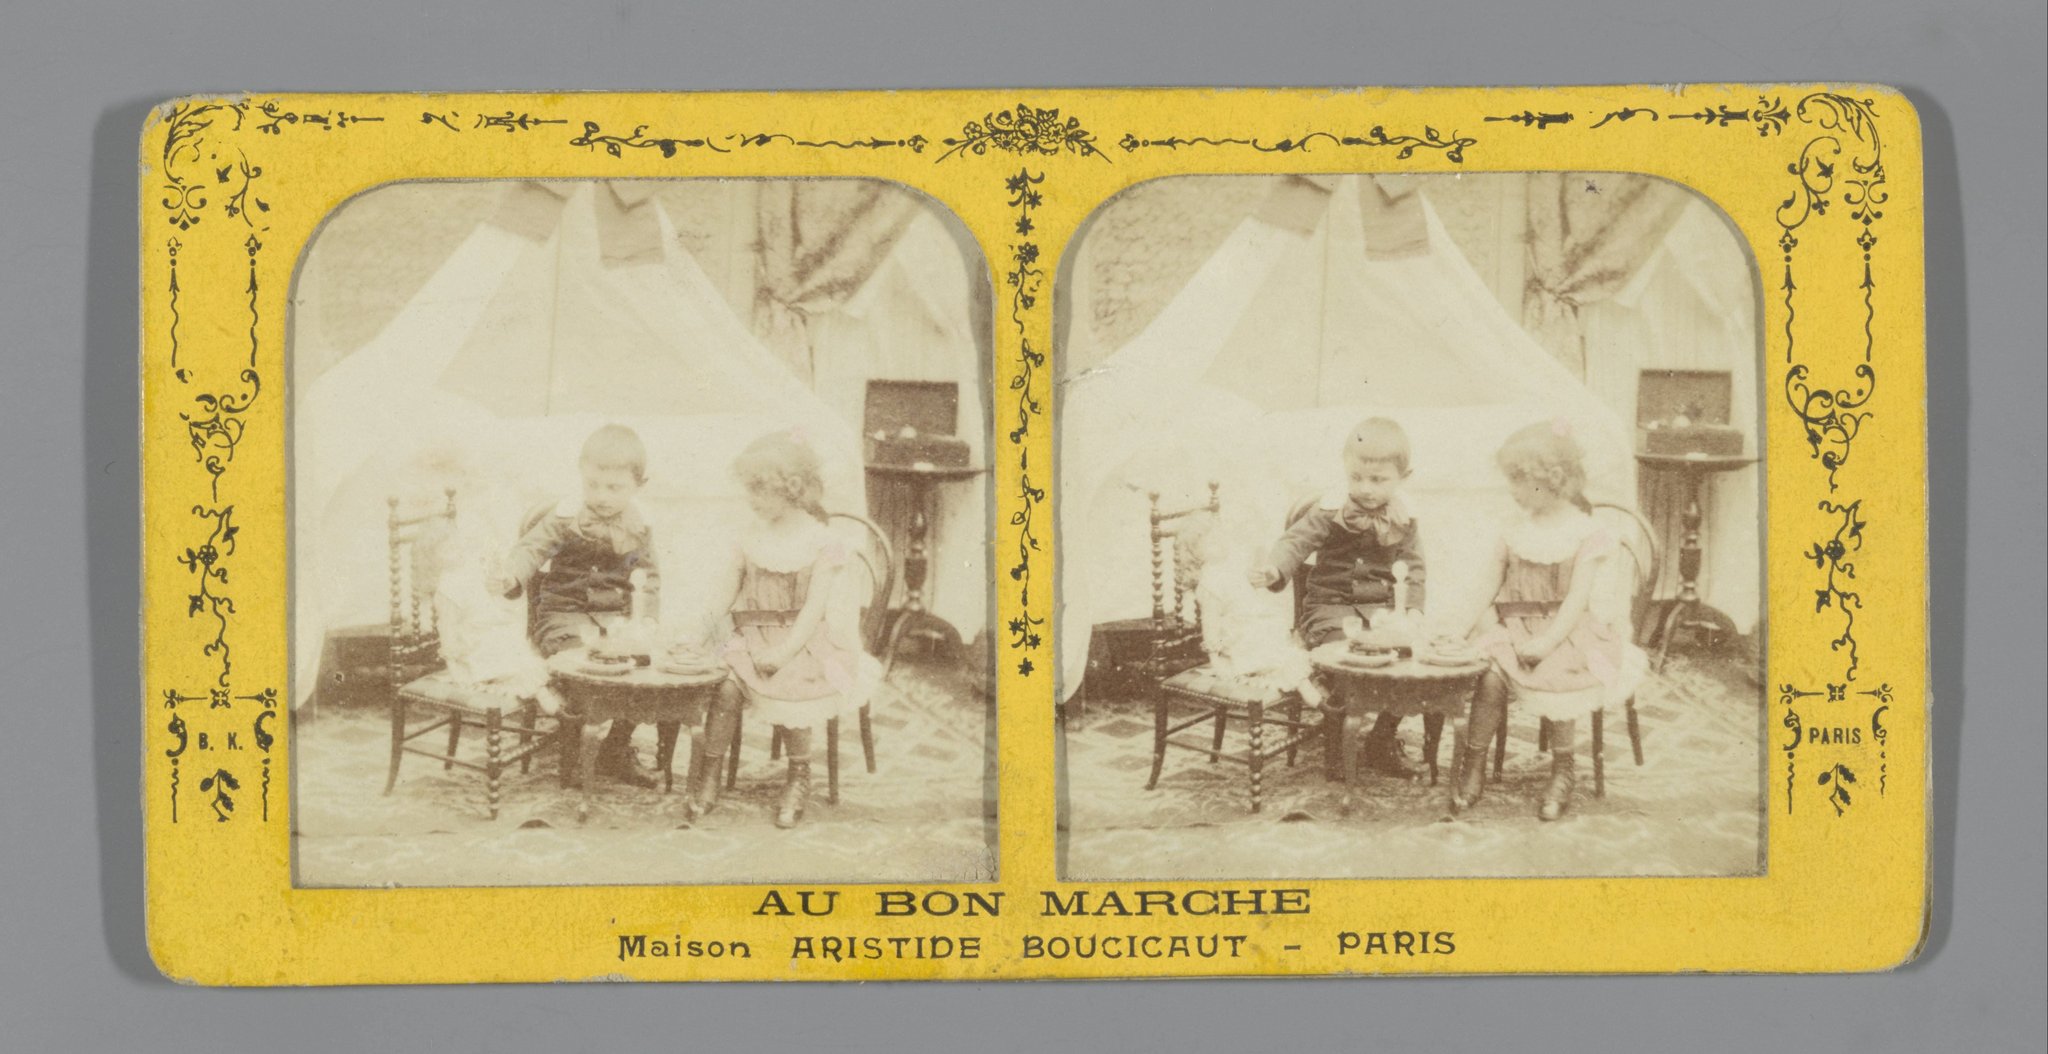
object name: tissue stereograph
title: La dinette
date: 1863-1875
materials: cardboard, paper, photographic support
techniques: albumen print, hand coloring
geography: paris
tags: children's games and plays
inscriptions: number: ‘10’, retailer's mark: ‘AU BON MARCHE/ Maison ARTISTIDE BOUCICAUT - PARIS’